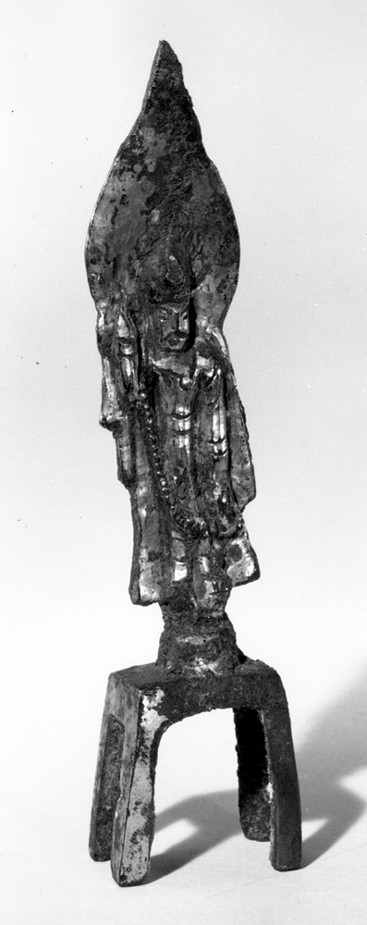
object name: figurine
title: Standing Buddha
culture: chinese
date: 618-907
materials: gilt bronze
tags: buddha